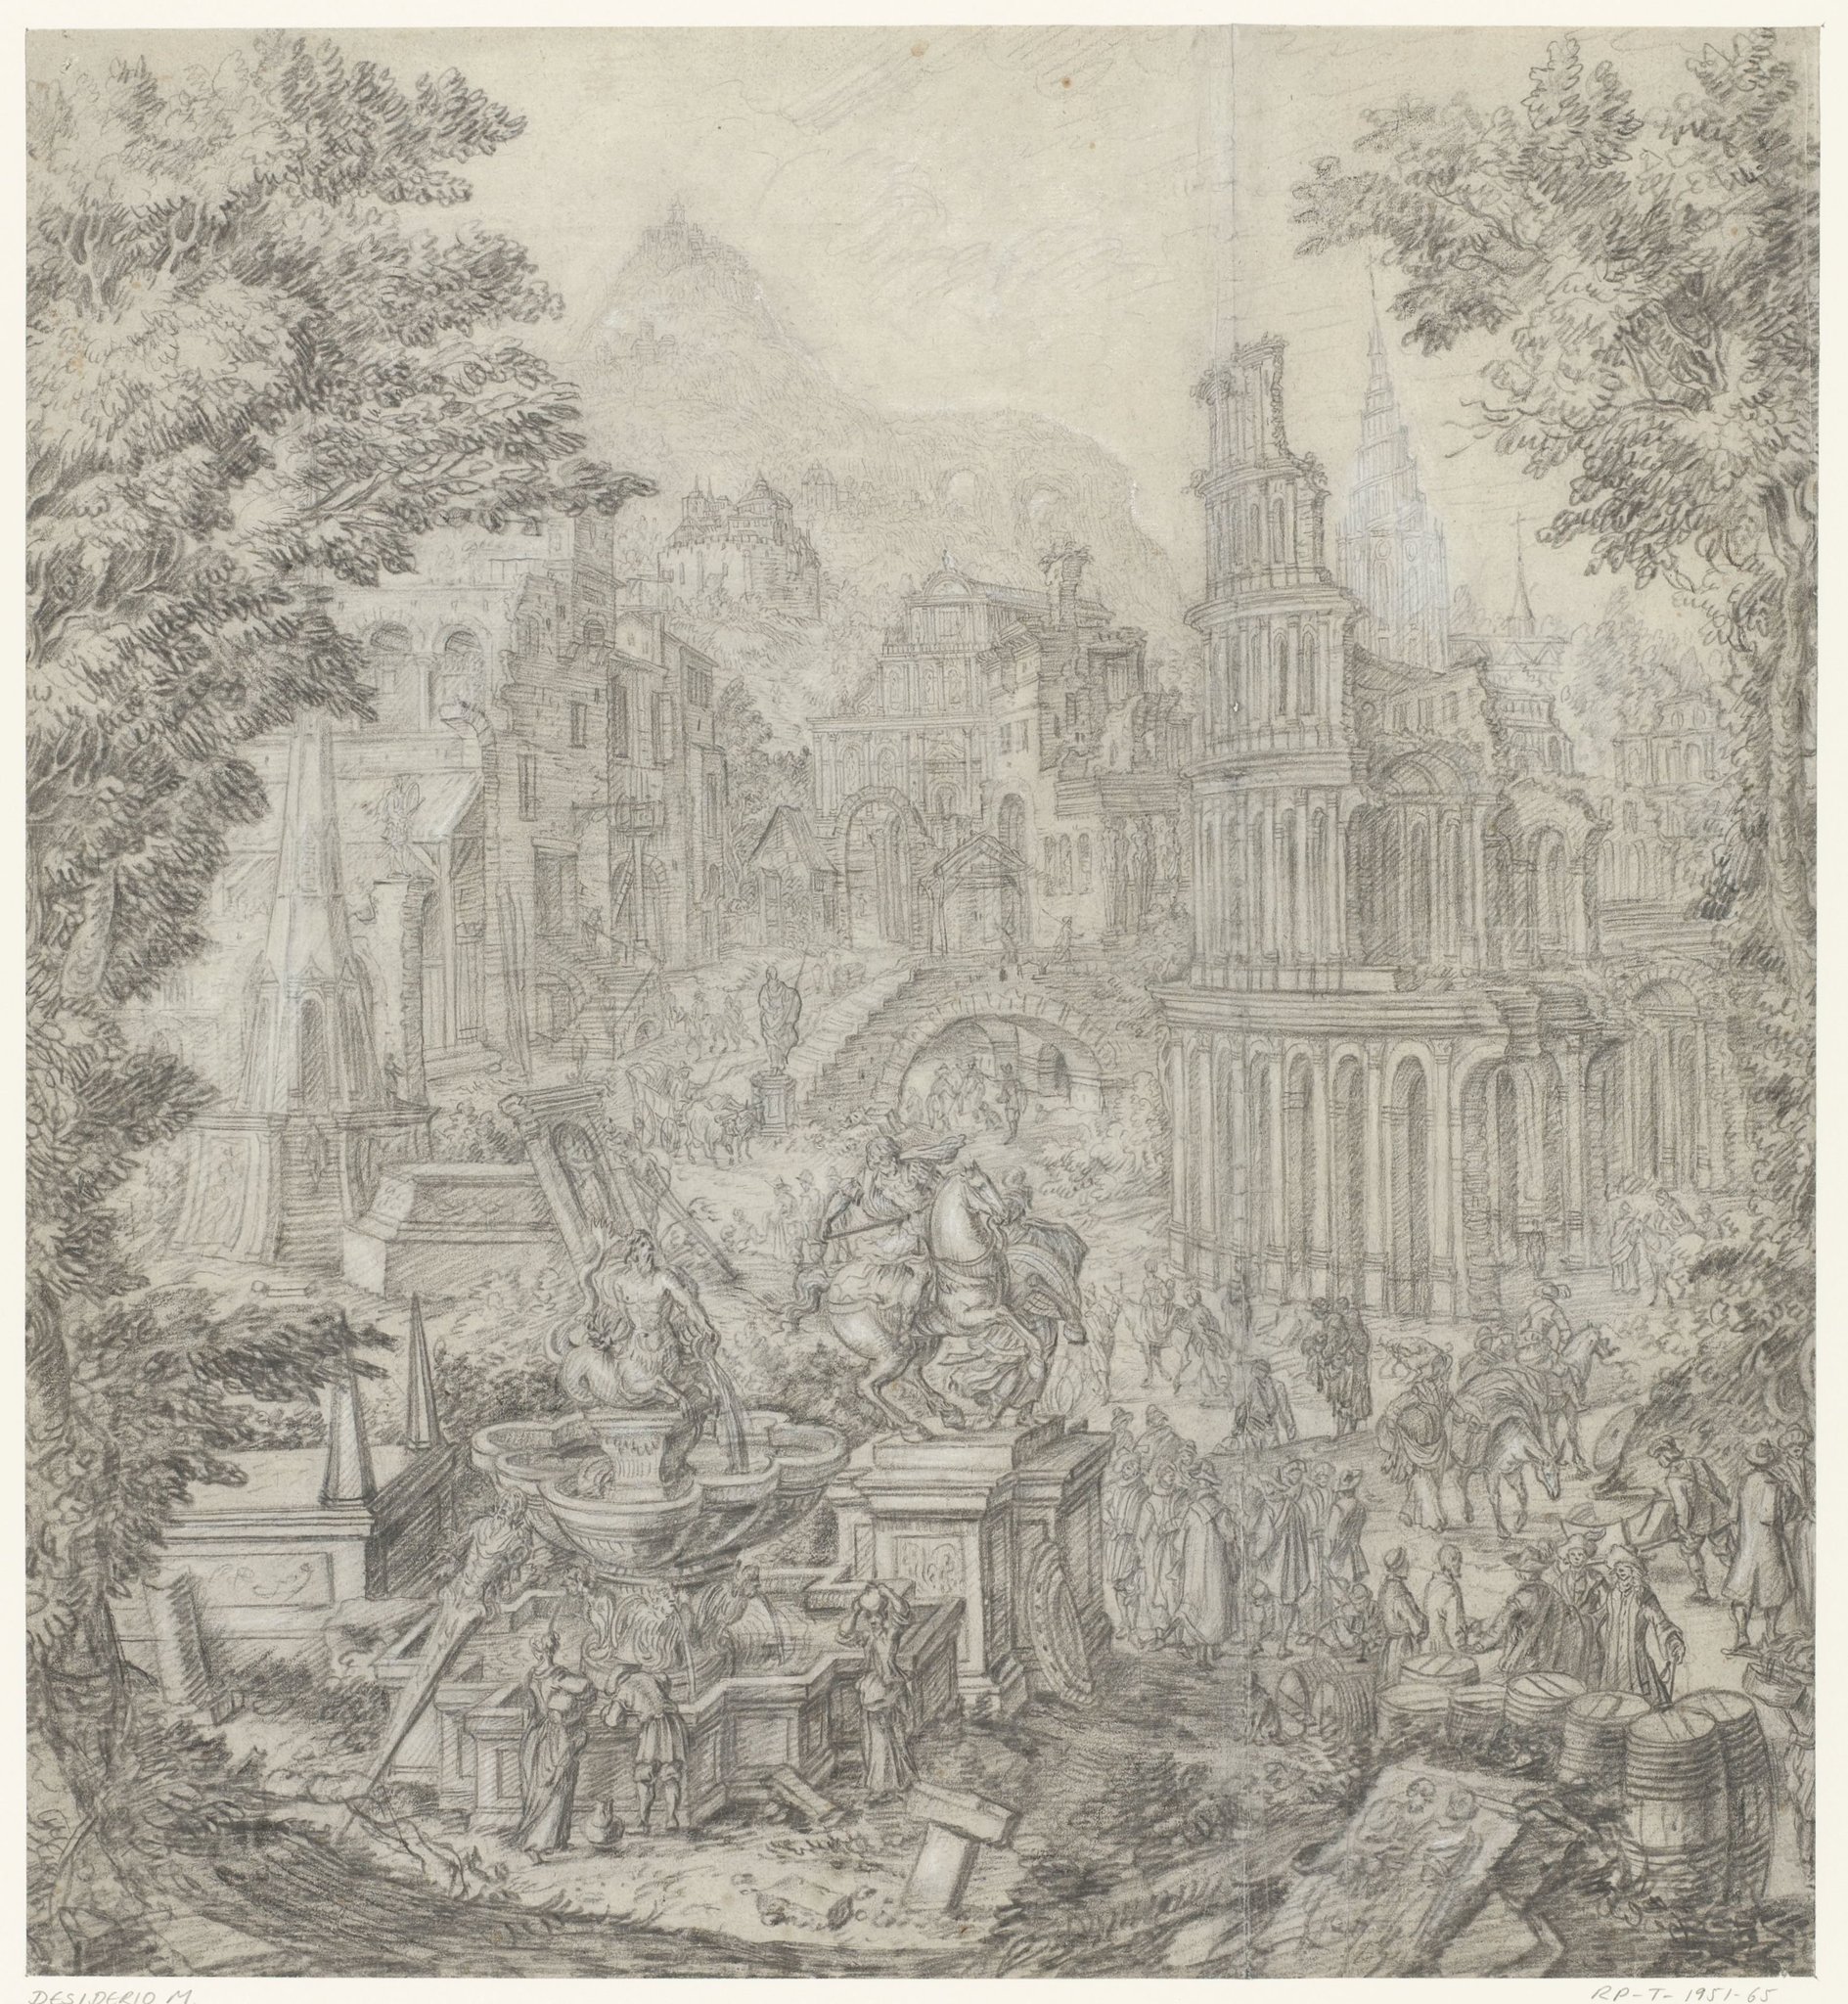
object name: drawing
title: Fantastisch landschap met gebouwen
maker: francesco desiderio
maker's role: draughtsman, print maker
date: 1600-1699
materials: chalk, paper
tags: fantastic architecture, unrealistic architectural fantasies